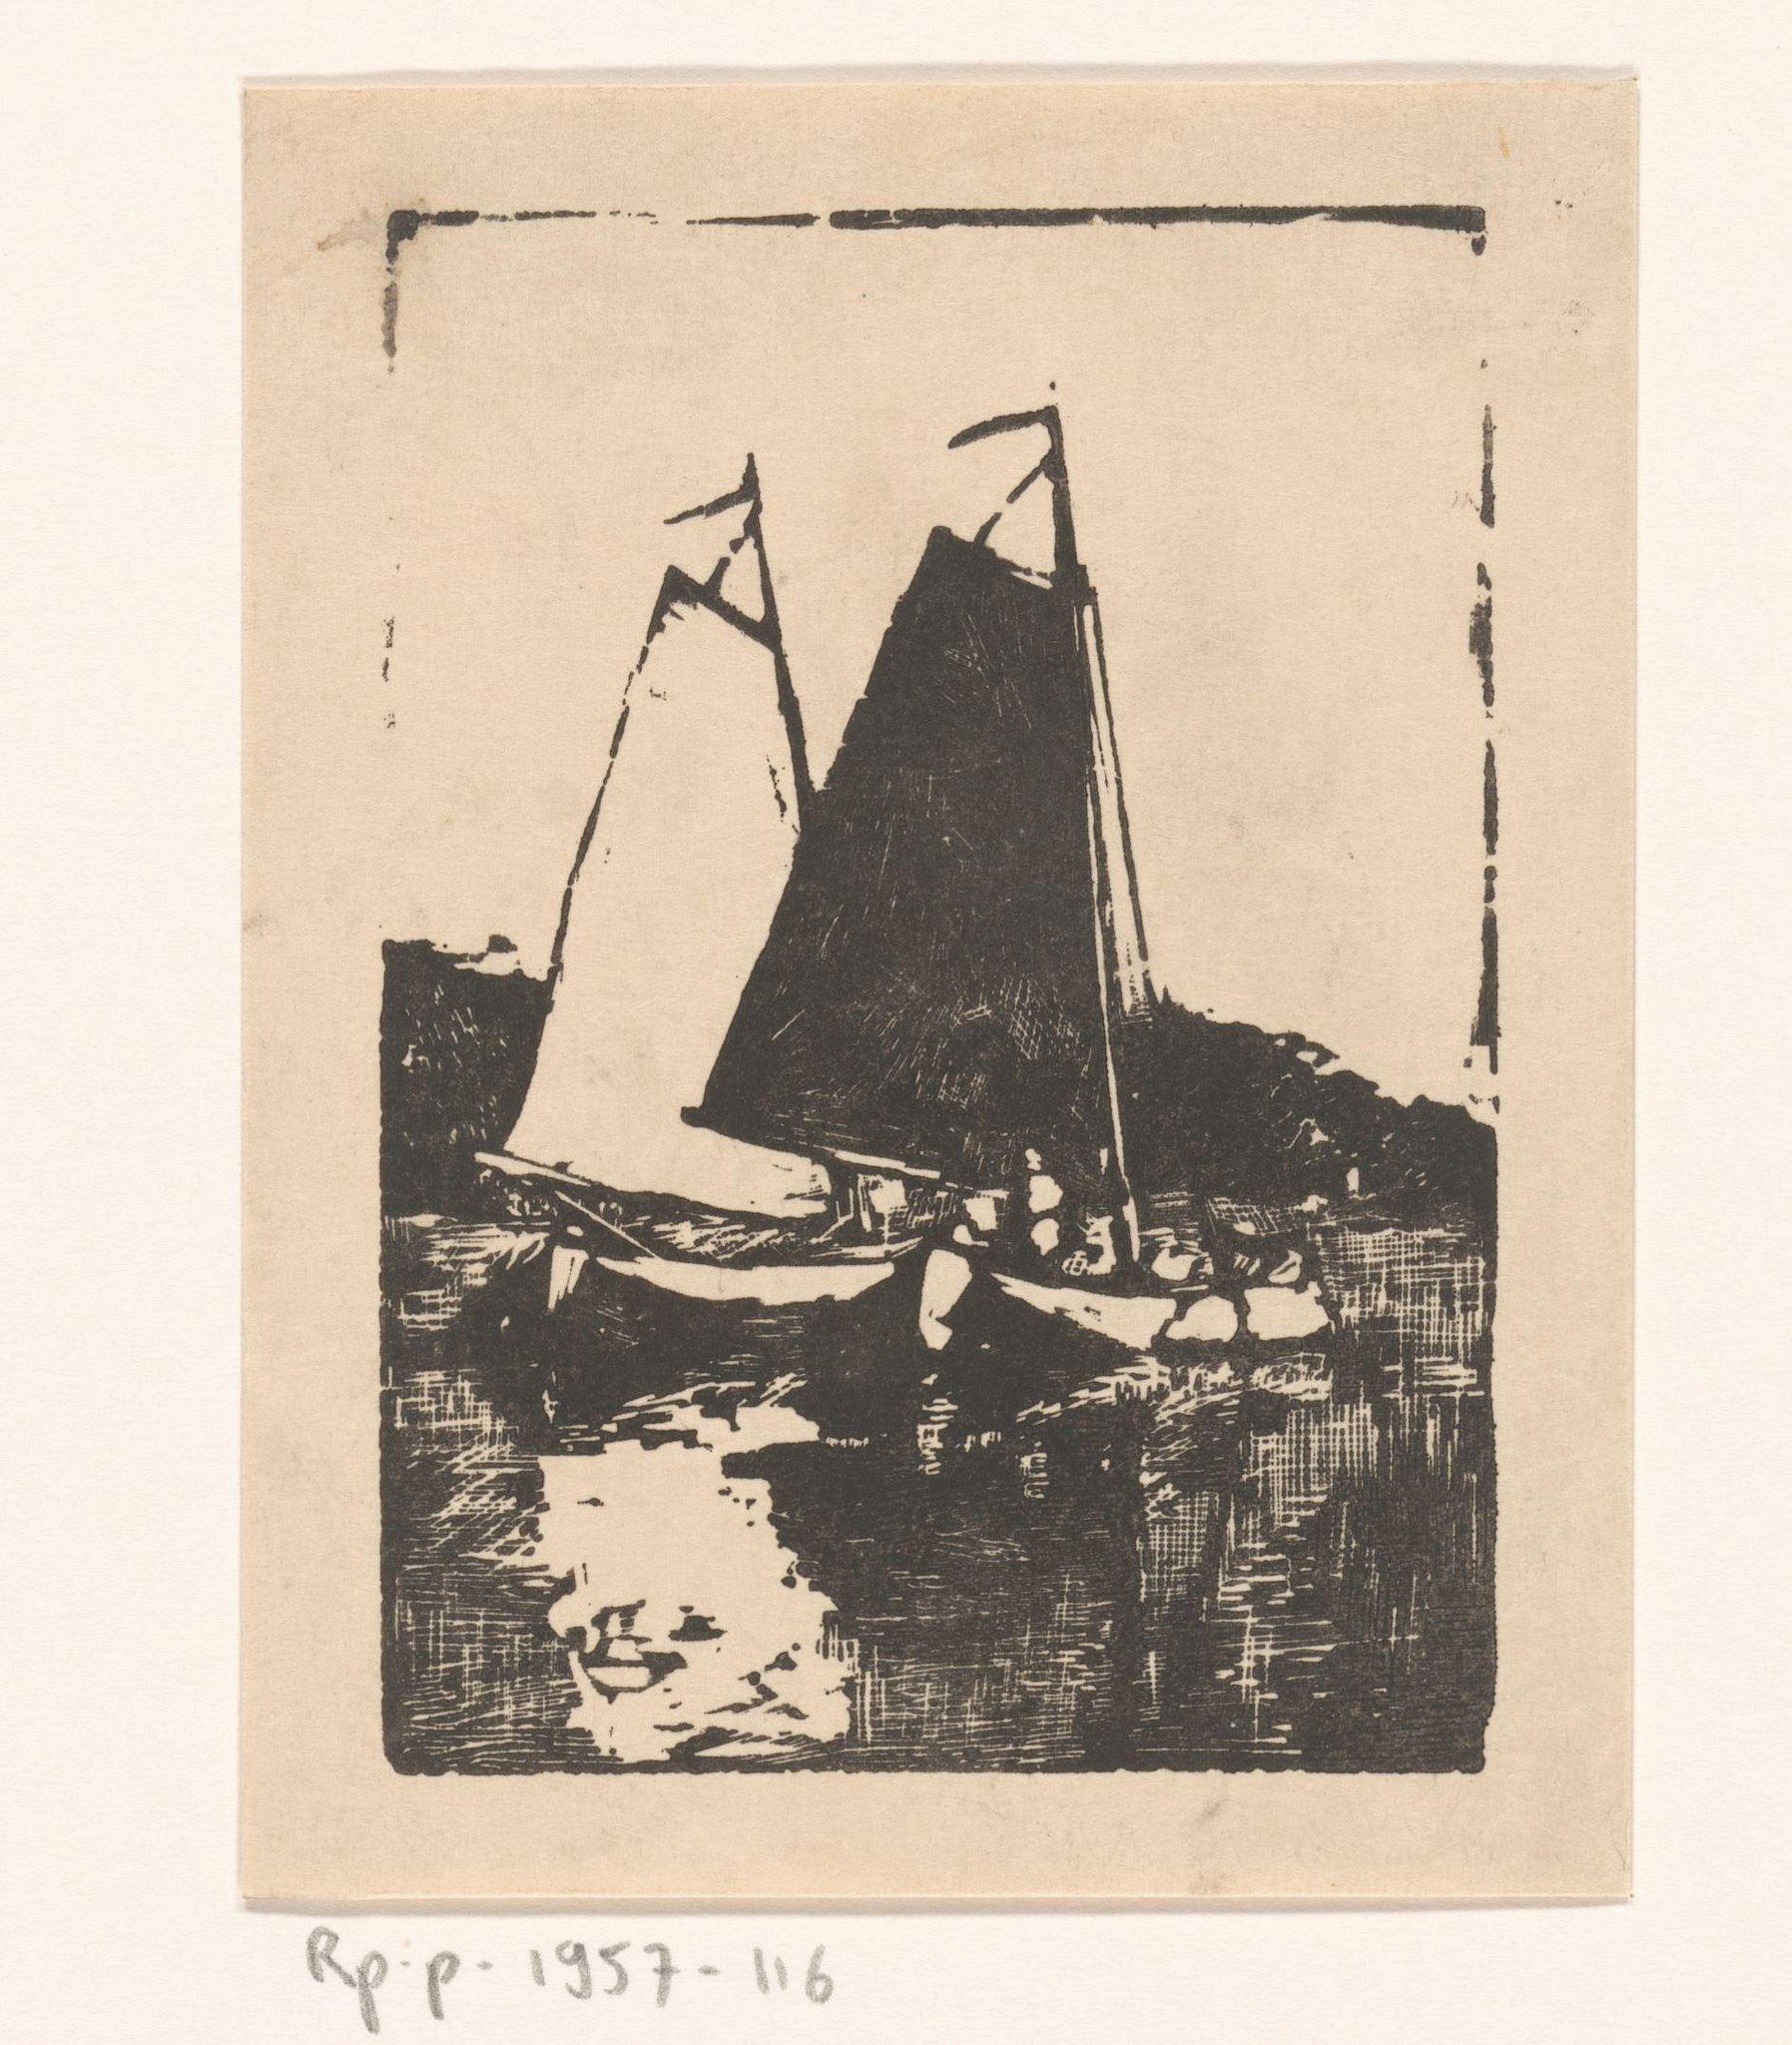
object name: print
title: Twee zeilschepen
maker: chris van der windt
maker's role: print maker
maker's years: 1877-1952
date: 1887-1952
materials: paper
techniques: woodcut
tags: sailing-ship, sailing-boat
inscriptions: collector's mark: Lugt 2228